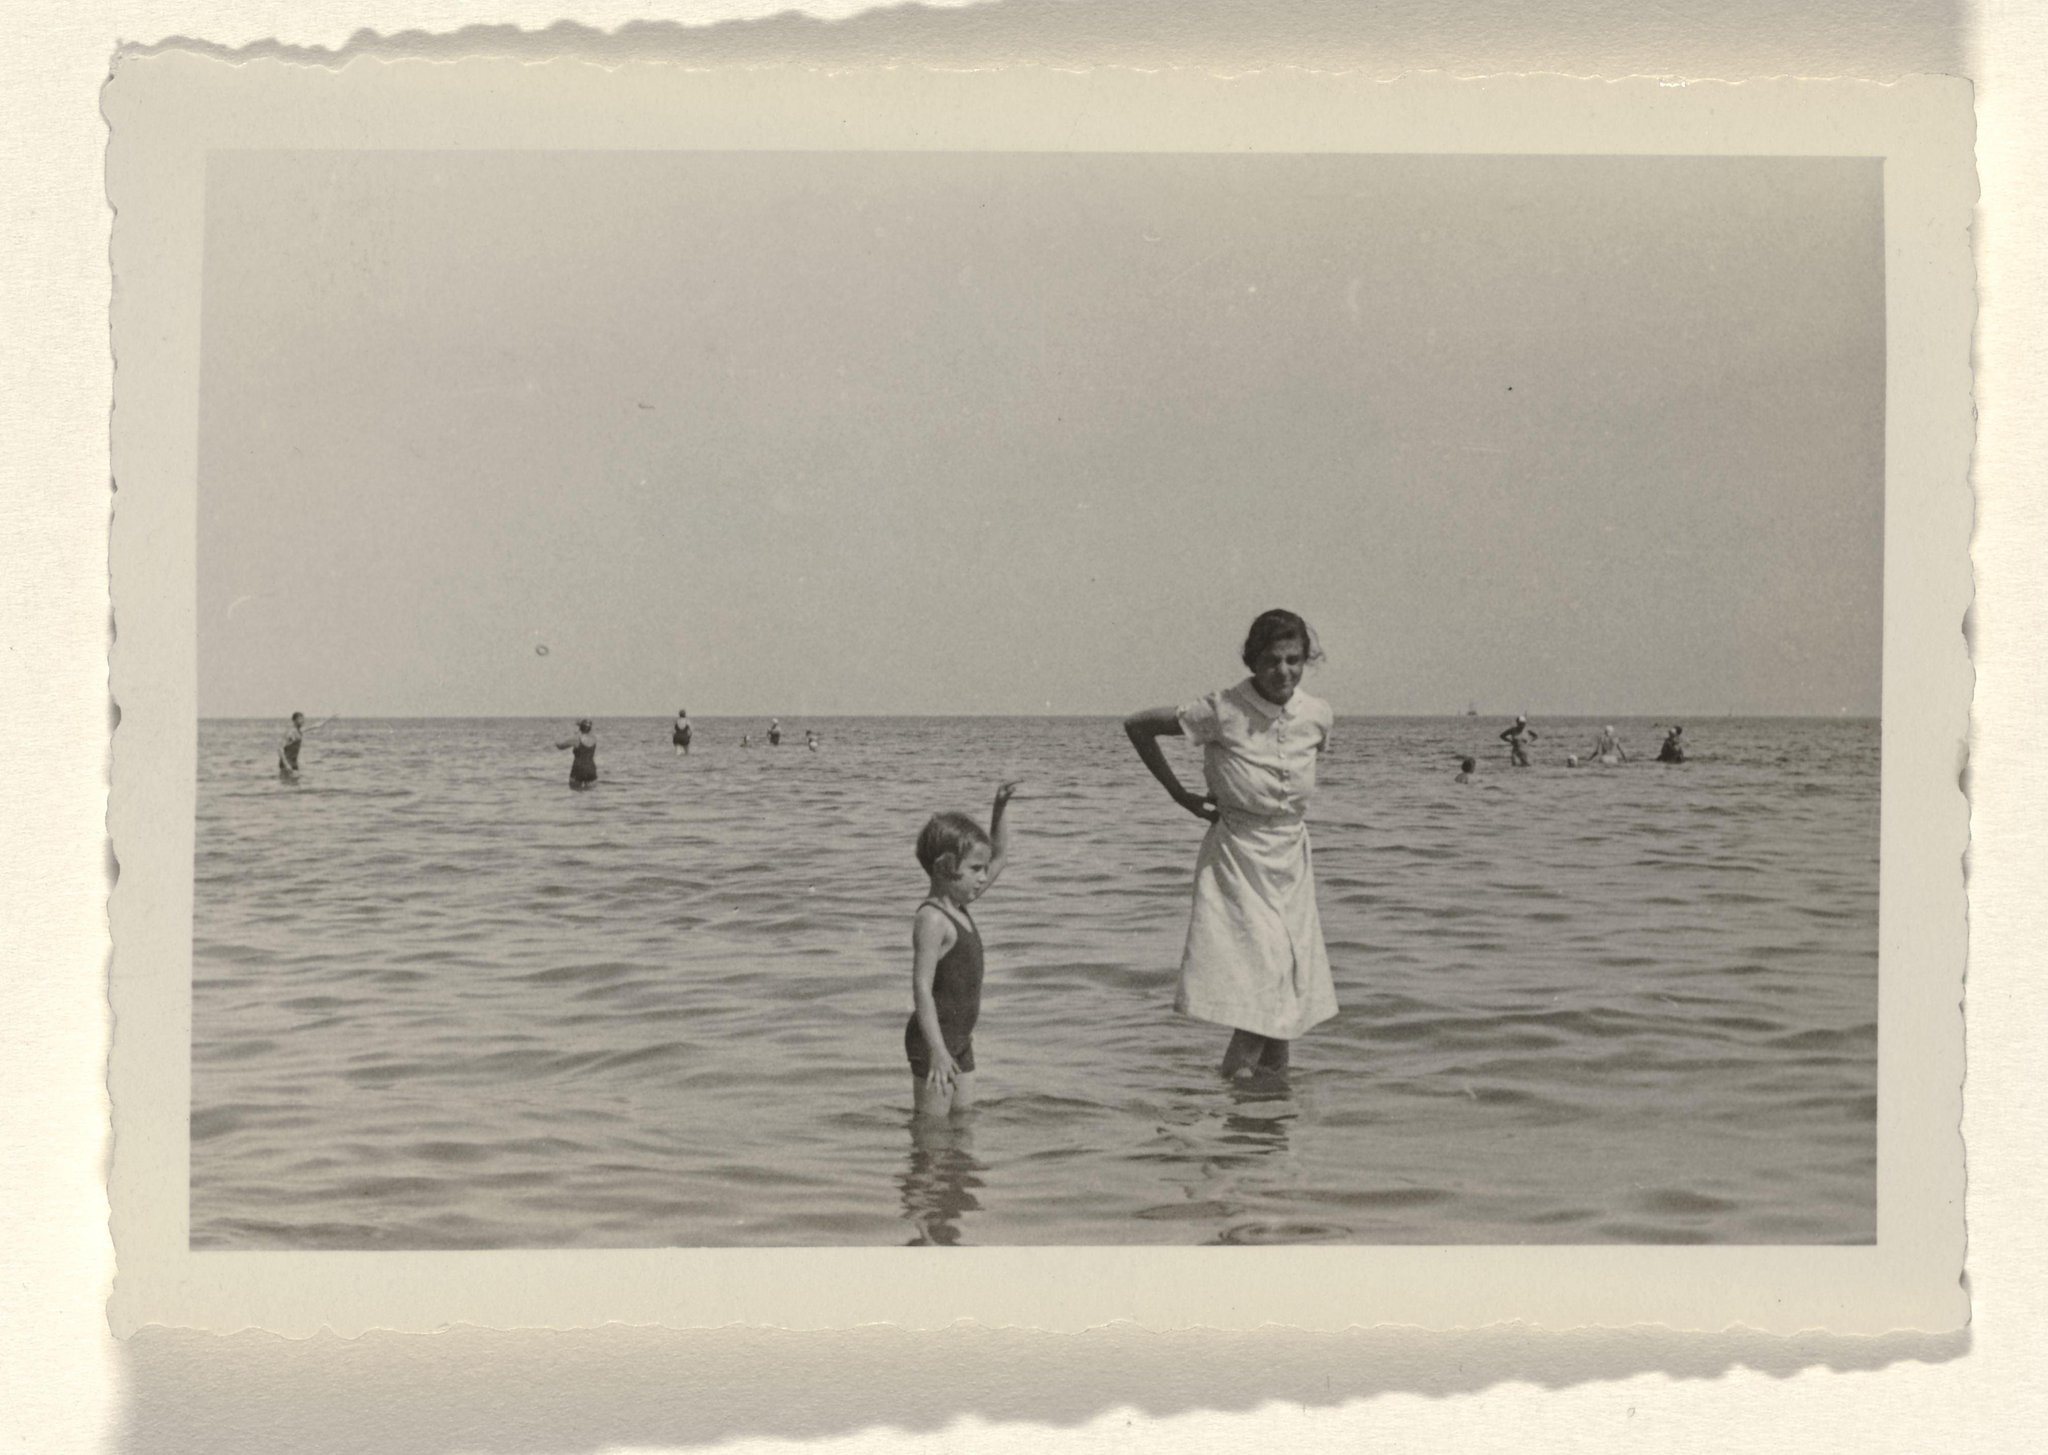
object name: photograph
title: Isabel Wachenheimer op strand van Travemünde, augustus 1933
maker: Anonymous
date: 1908-1933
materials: photographic support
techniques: gelatin silver print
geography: travemünde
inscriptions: date: ‘Aug.33. Travemünde’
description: Dit object is onderdeel van de nalatenschap van Isabel Elon-Wachenheimer (1928-2010). Tot haar overlijden behoorde het samen met de andere objecten uit de nalatenschap tot haar privédomein van Isabel Wachenheimer. In die particuliere context zijn deze objecten tezamen en individueel aandenkens - aan de jeugd, ouders en familie van Isabel Wachenheimer vóór en tijdens de Shoah en aan haar leven na de Tweede Wereldoorlog. Isabel Wachenheimer, die van juni 1943 tot mei 1945 gevangen zat in Kamp Westerbork, Theresienstadt, Auschwitz, Lenzing a/d Oberdonau (een buitenkamp van Mauthausen), overleefde de Shoah. Haar ouders – Eugène Wachenheimer en Else Wachenheimer-Moos - werden op 14 oktober 1944 in Auschwitz-Birkenau vermoord.